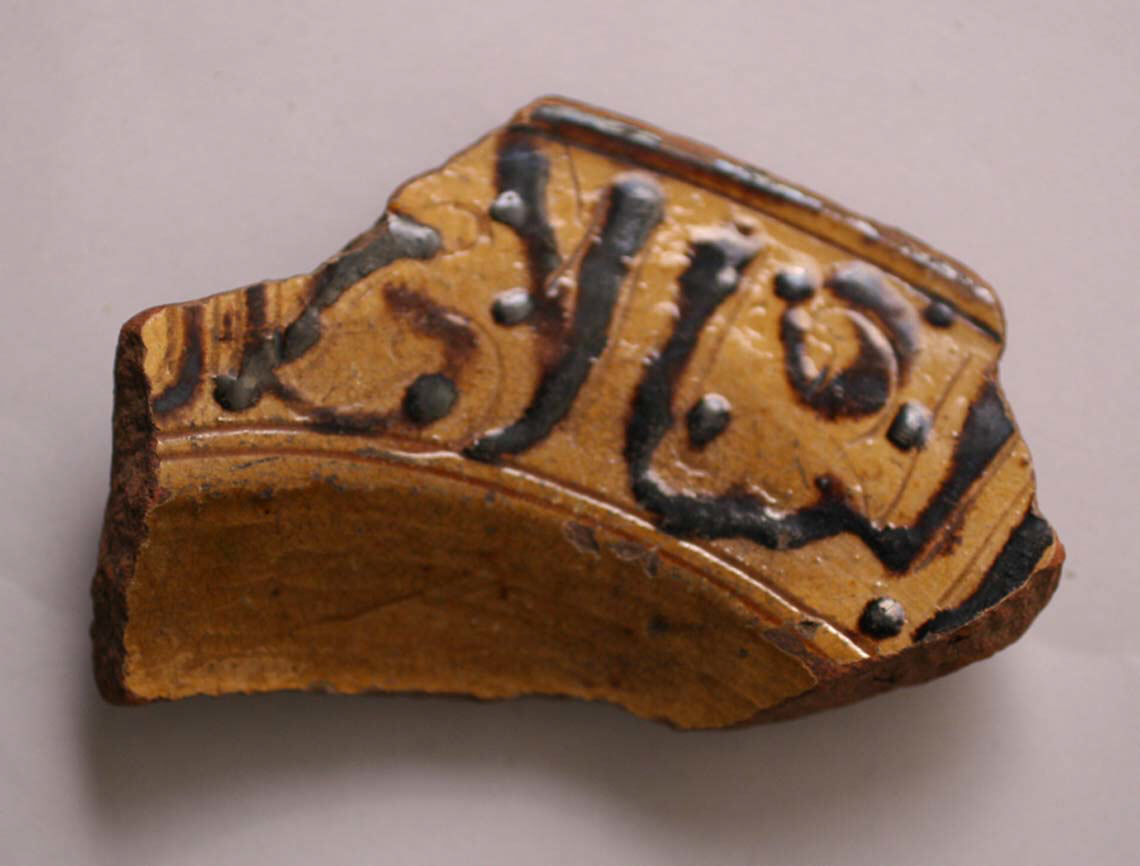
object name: ceramic fragment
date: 1301-1500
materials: earthenware, glaze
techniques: coloring, incising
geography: egypt